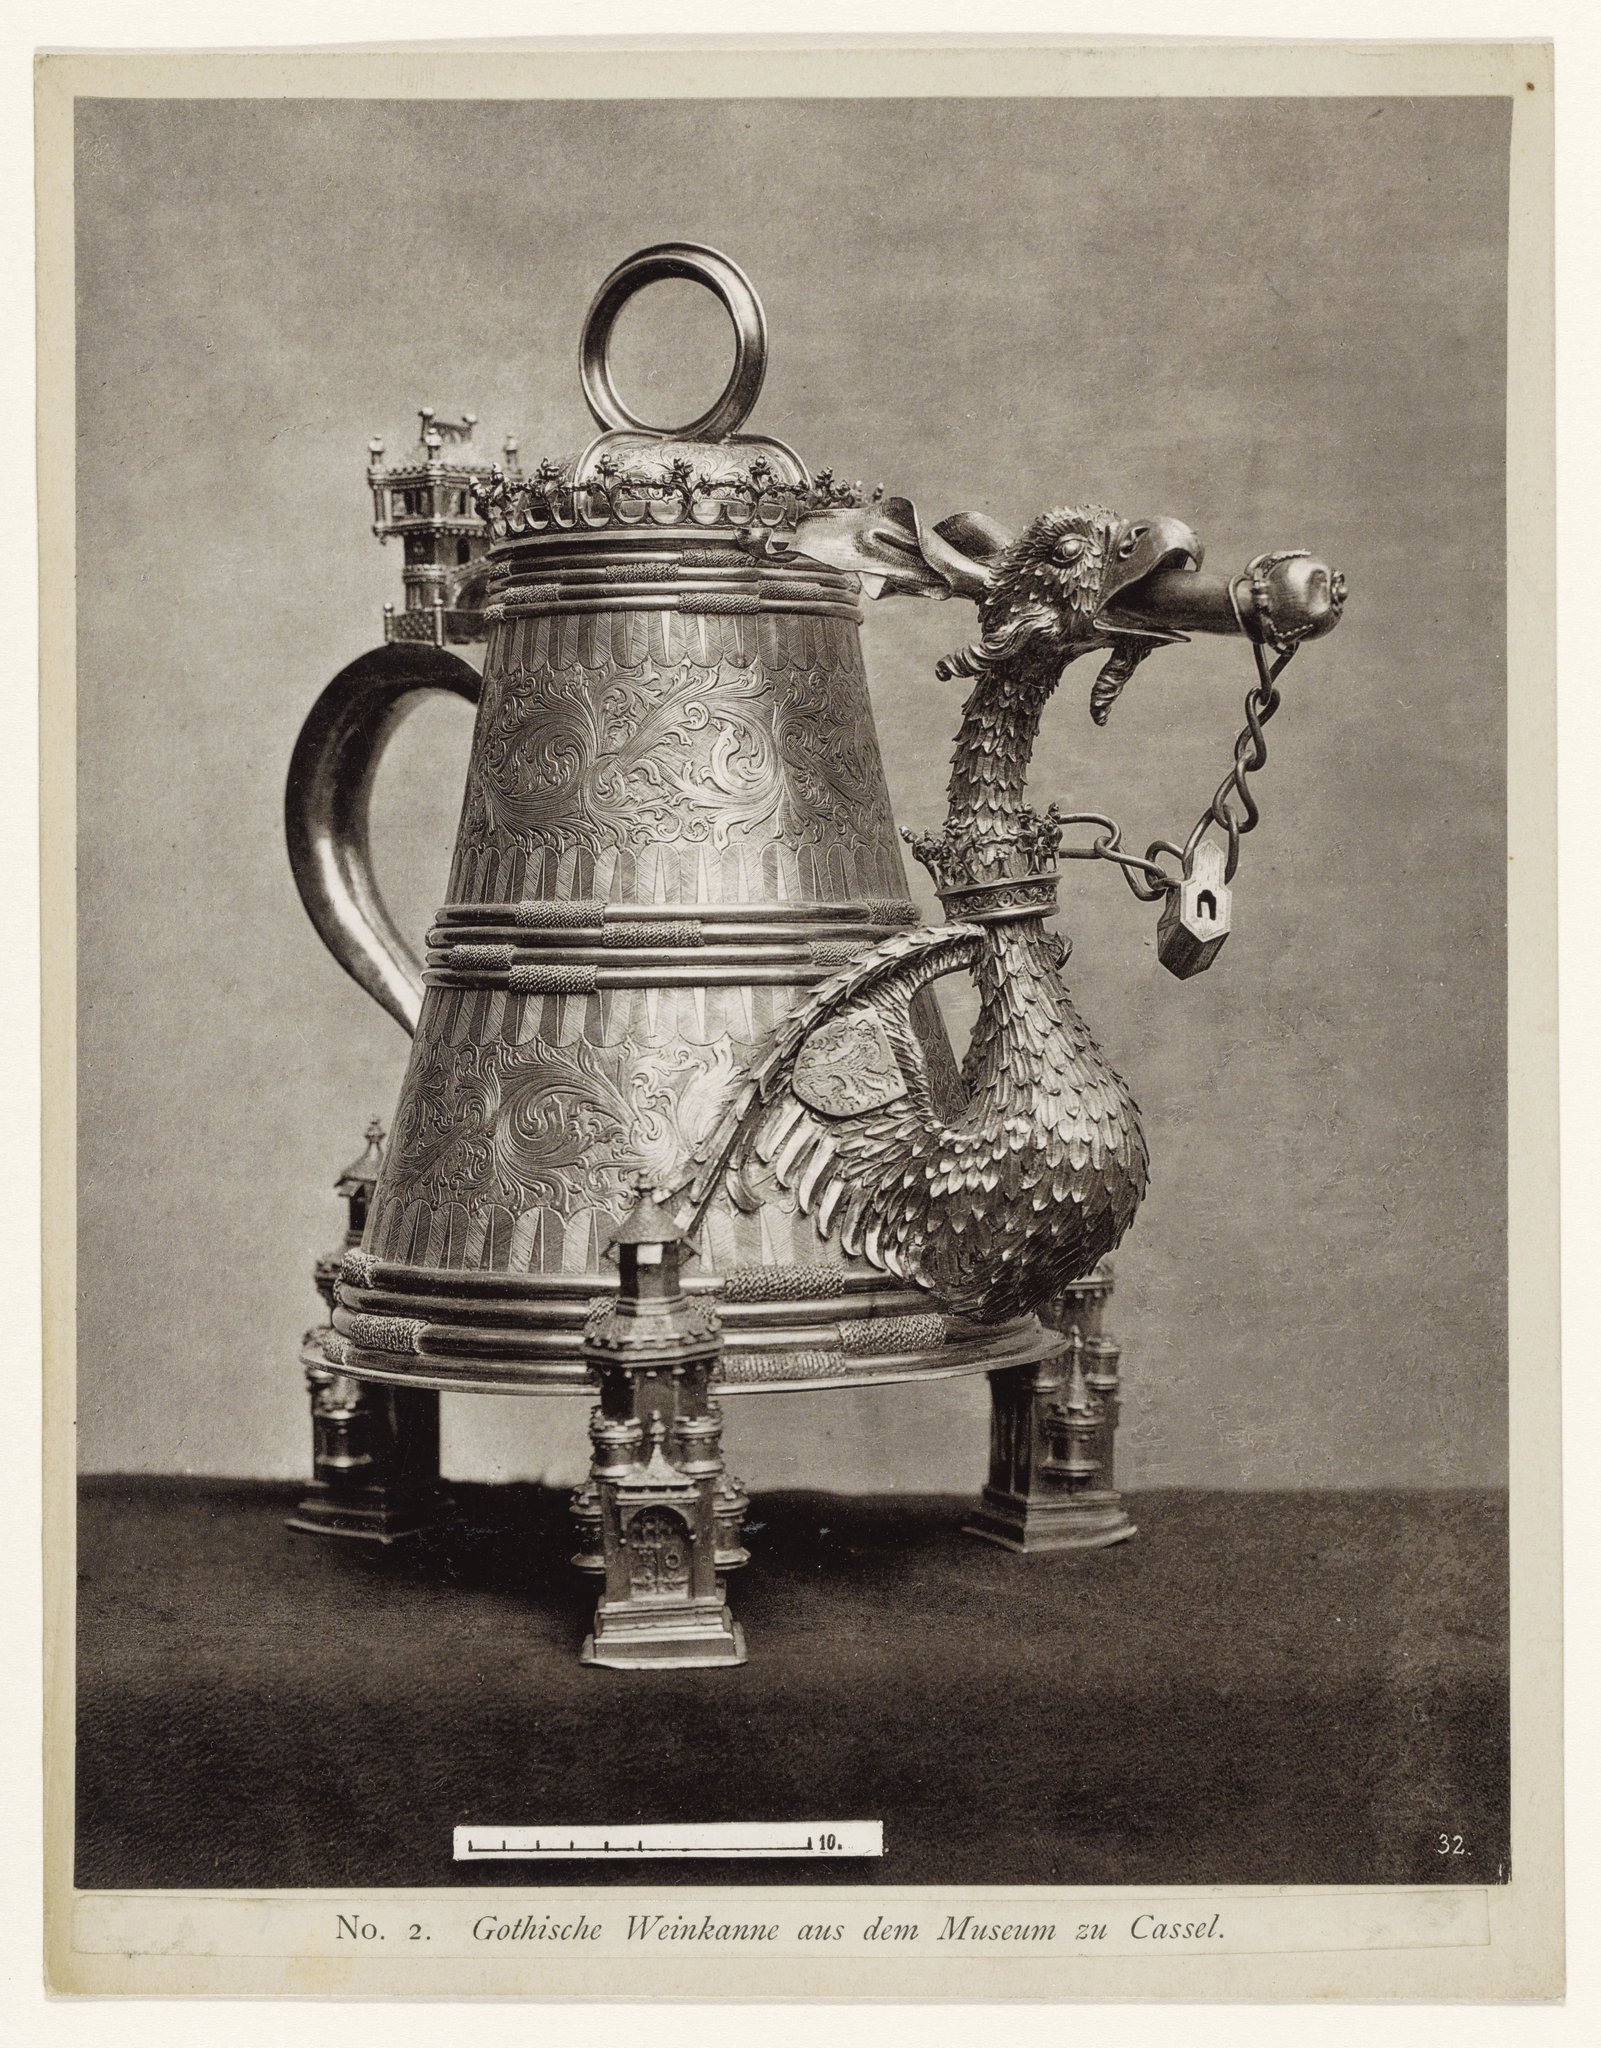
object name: photomechanical print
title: Gotische wijnkaraf met decoraties, Kassel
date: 1869-1887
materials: cardboard, paper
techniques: photograph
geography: munich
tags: animal-shaped drinking-vessel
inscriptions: number: ‘32’, title: ‘No. 2. Gothische Weinkanne aus dem Museum zu Cassel.’